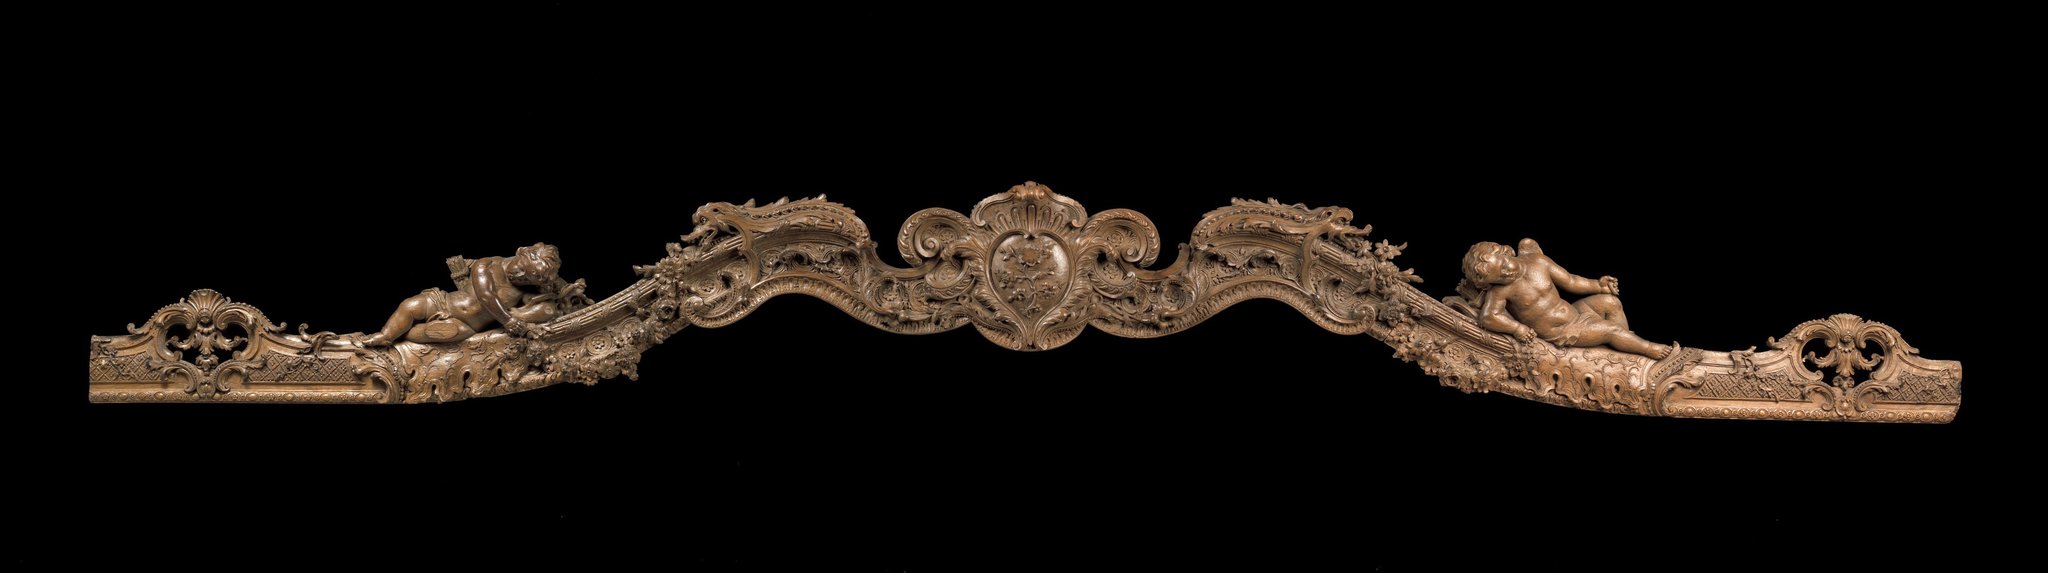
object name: settee rail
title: Crest rail of a settee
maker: françois roumier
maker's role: maker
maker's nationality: french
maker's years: 1701-1748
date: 1601-1800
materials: wood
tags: sleeping,putti